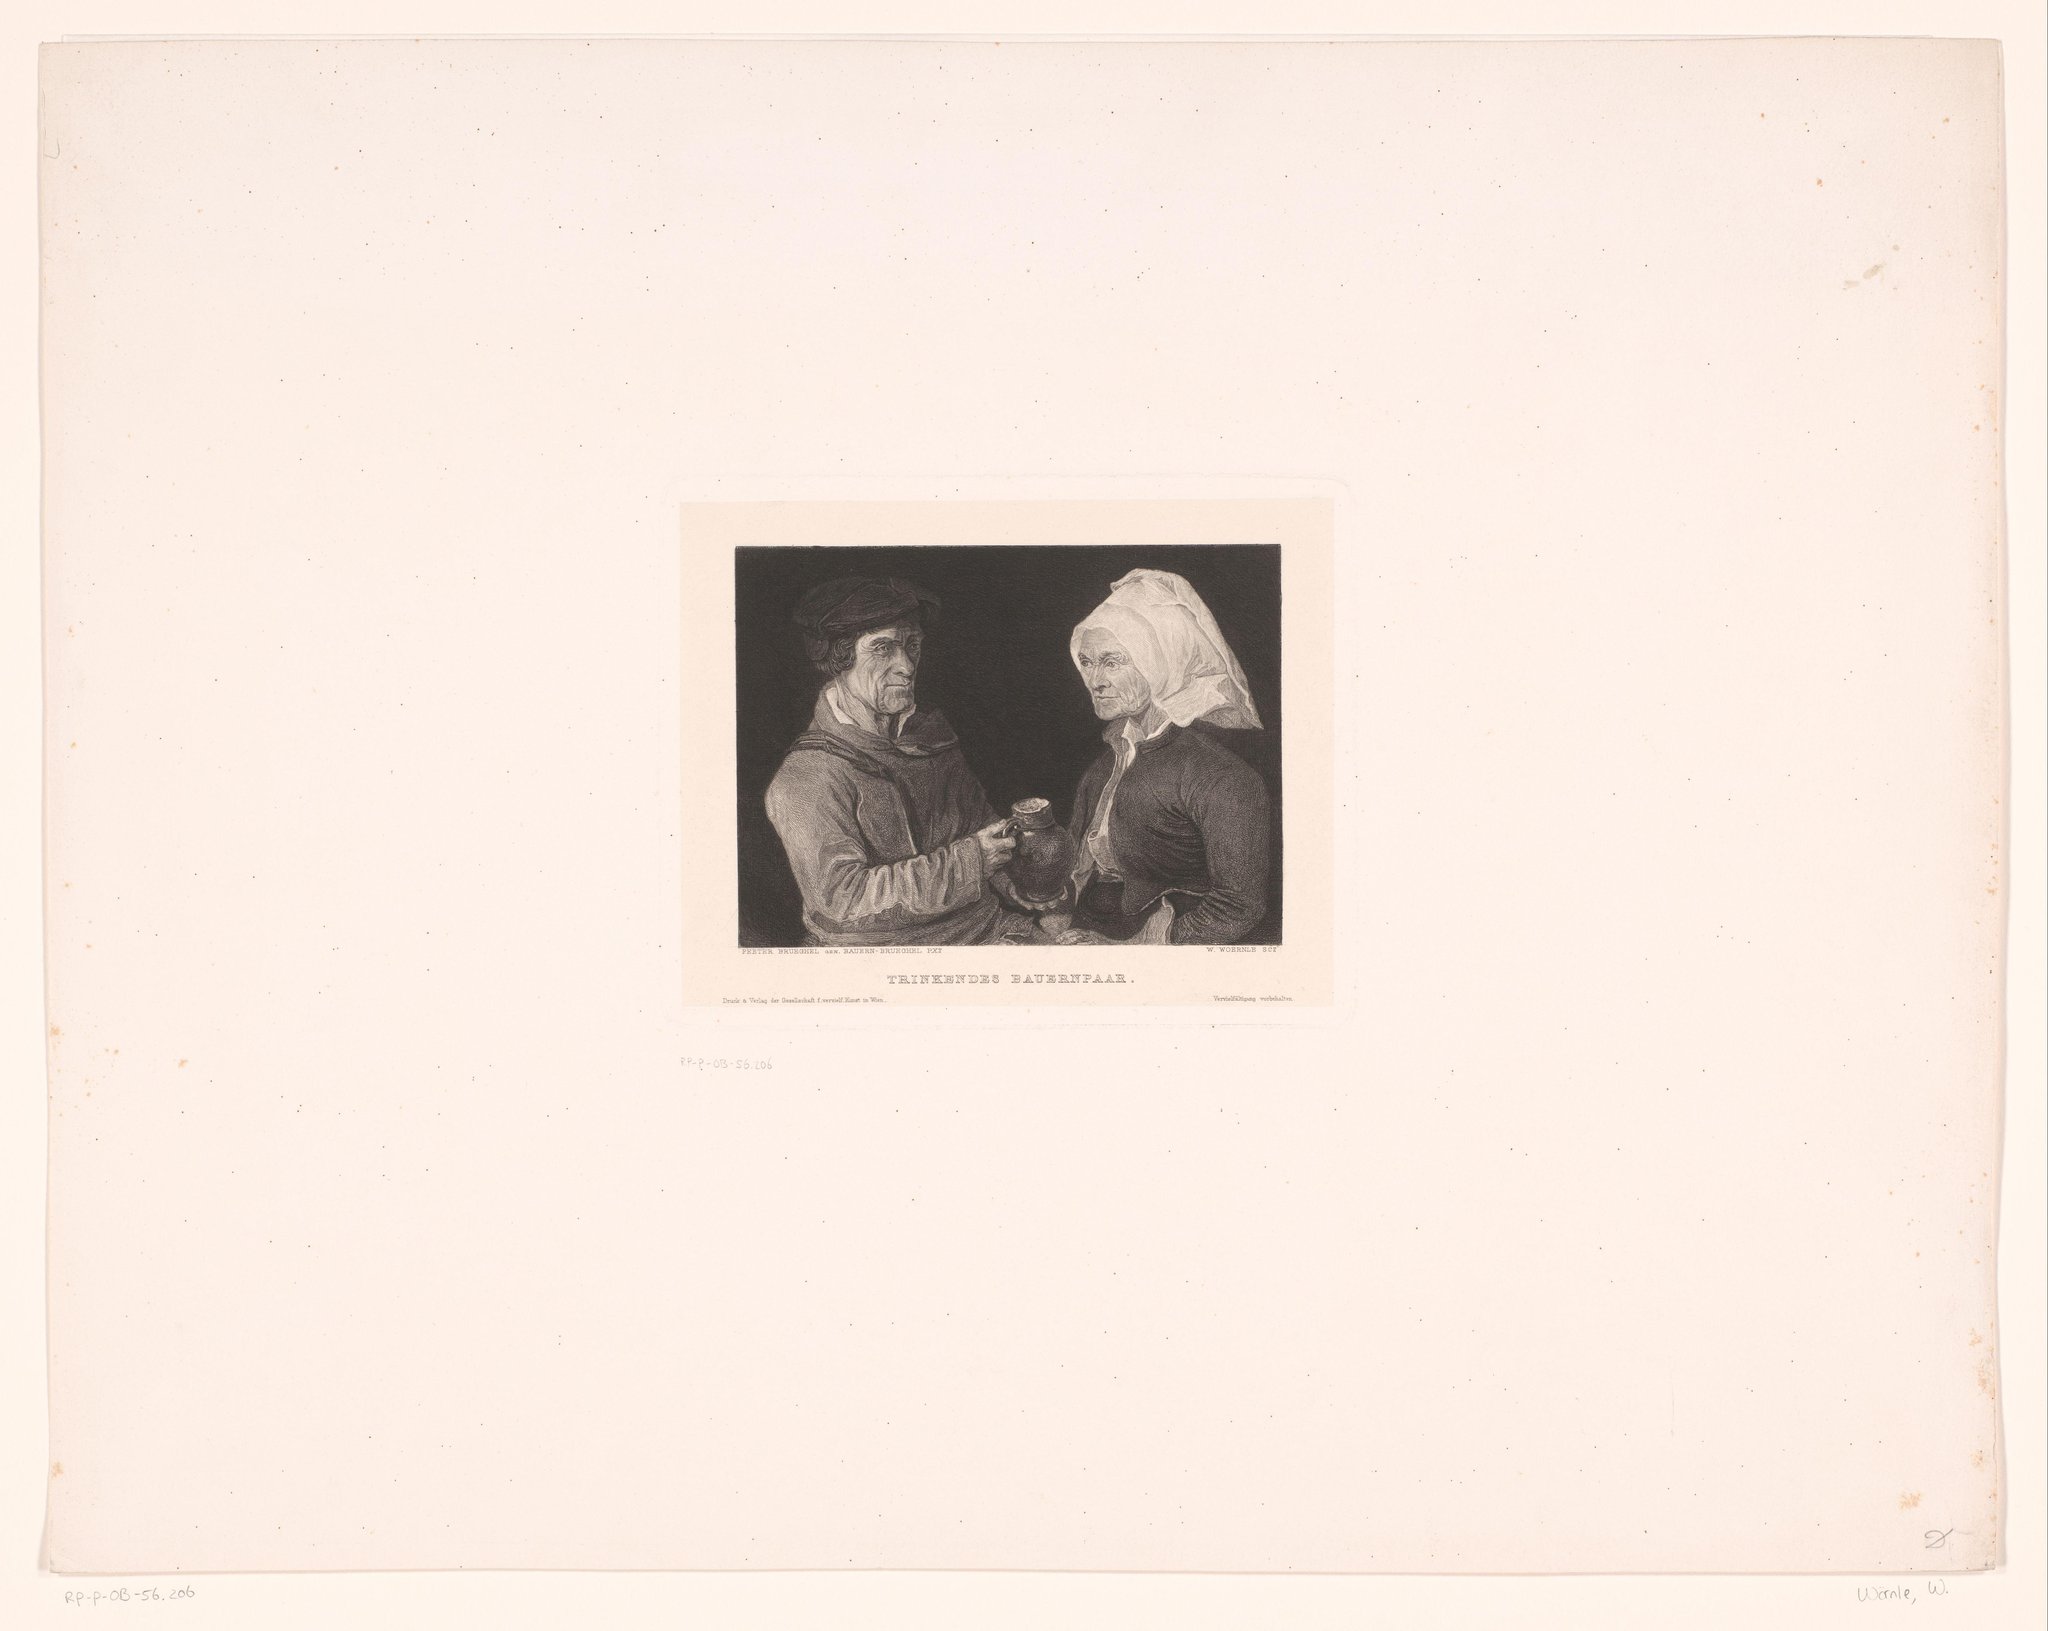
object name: print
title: Trinkendes Bauernpaar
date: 1859-1916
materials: paper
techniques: etching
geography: vienna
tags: historical persons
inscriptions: collector's mark: Lugt 2228